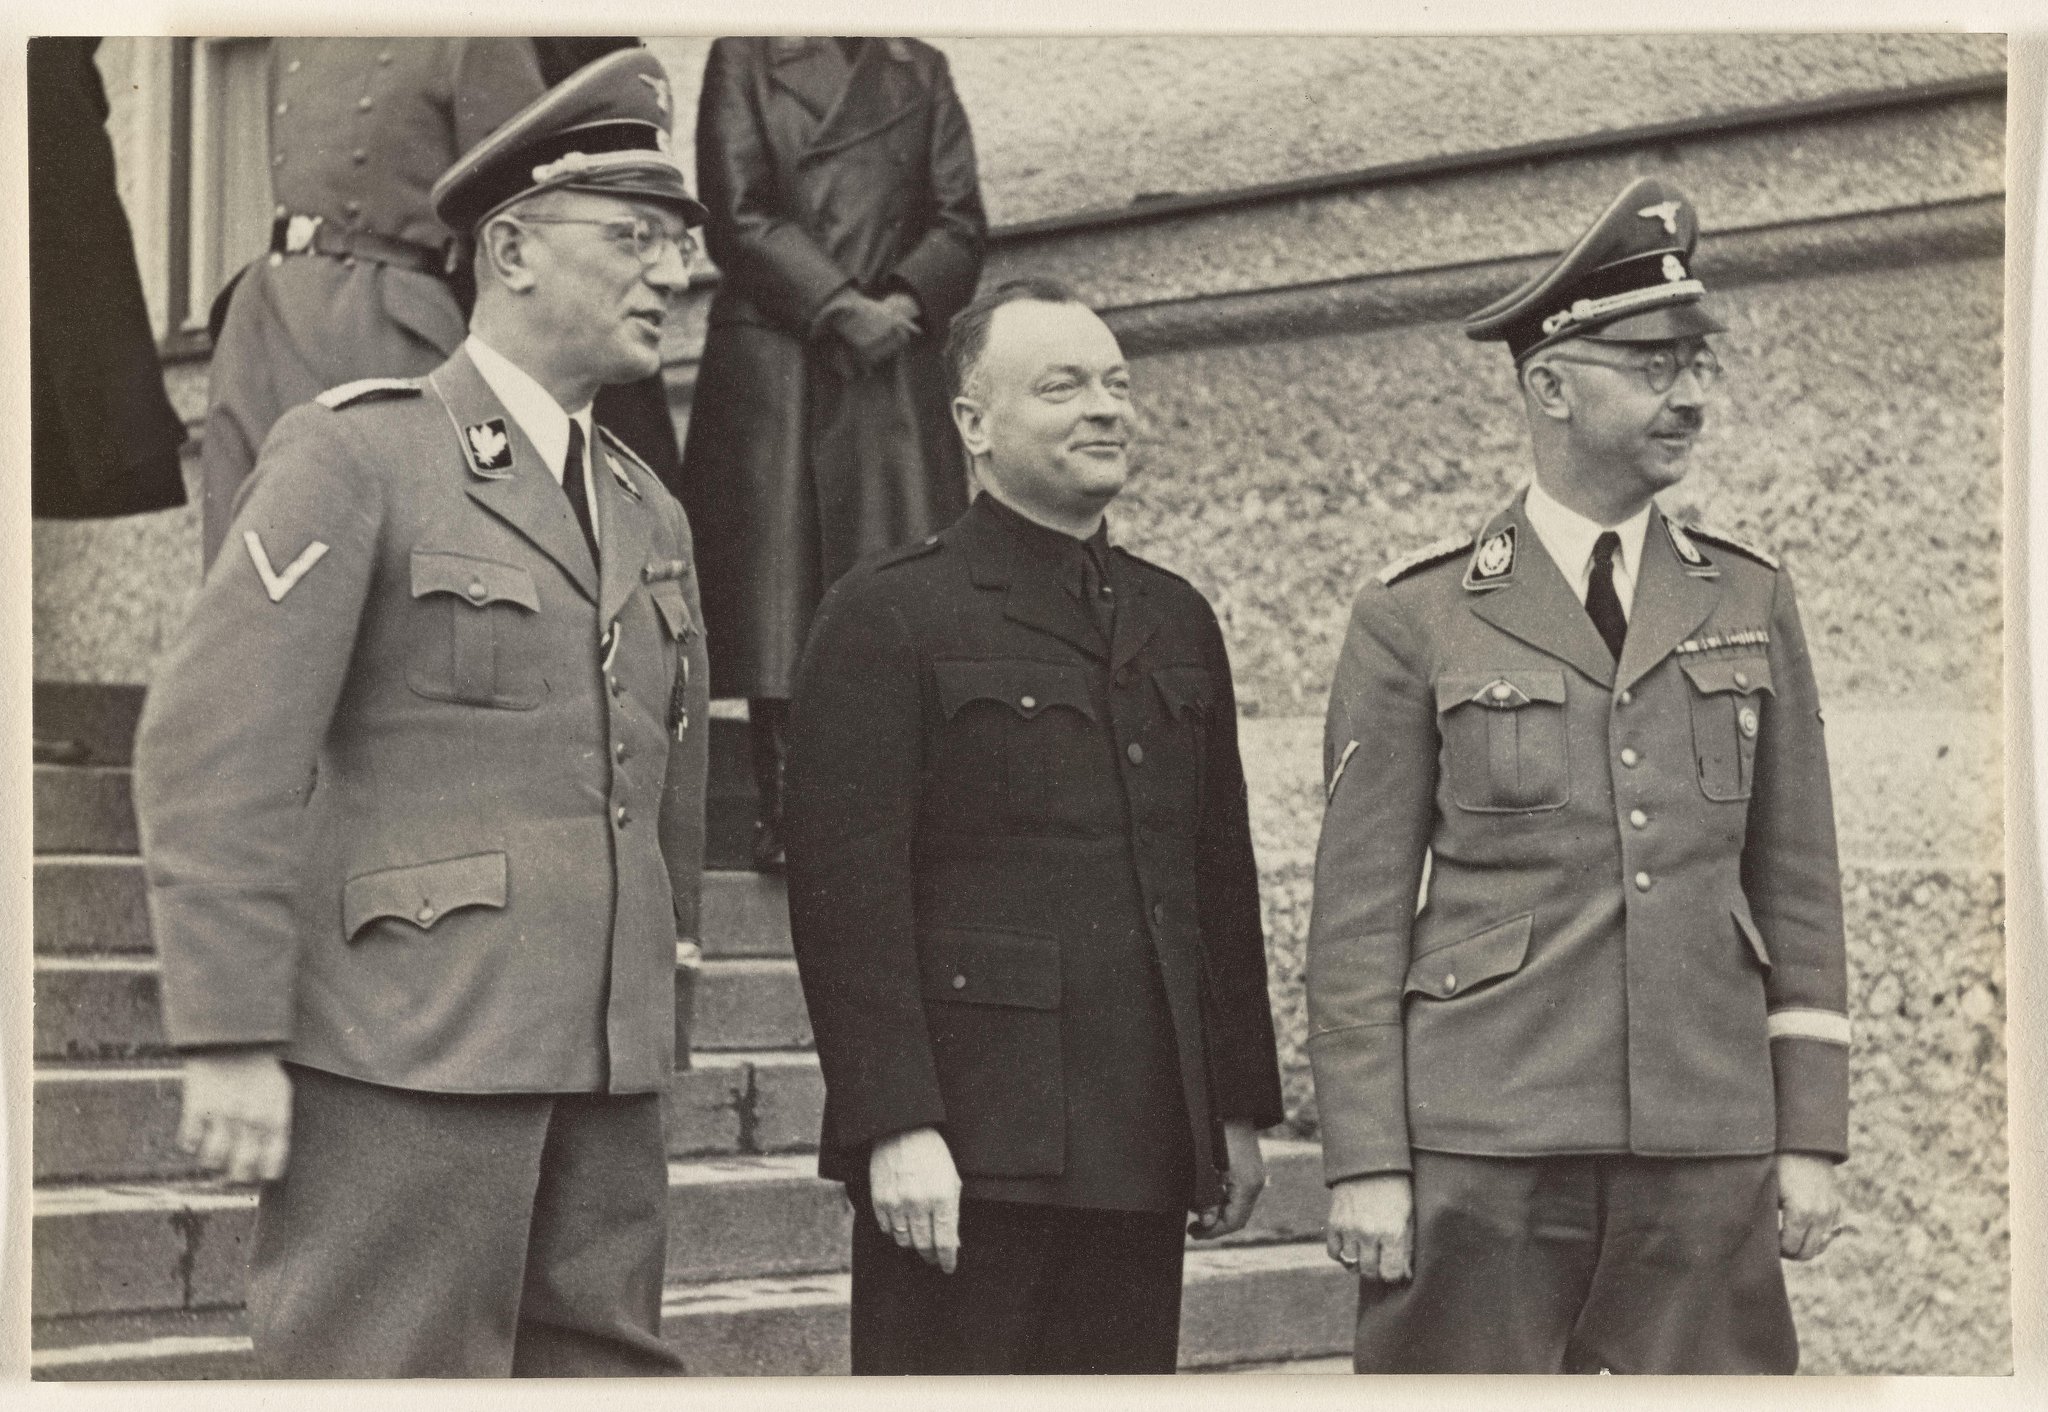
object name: photograph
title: Seyss Inquart, Mussert en Himmler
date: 1940-1944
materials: photographic support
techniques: photography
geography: netherlands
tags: netherlands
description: Drie militairen poserend voor een trap in uniform. Van links naar rechts: A. Seyss Inquart, Rijkscommissaris voor bezet Nederland, A. Mussert, leider van de NSB en H. Himmler, Reichsführer der SS.